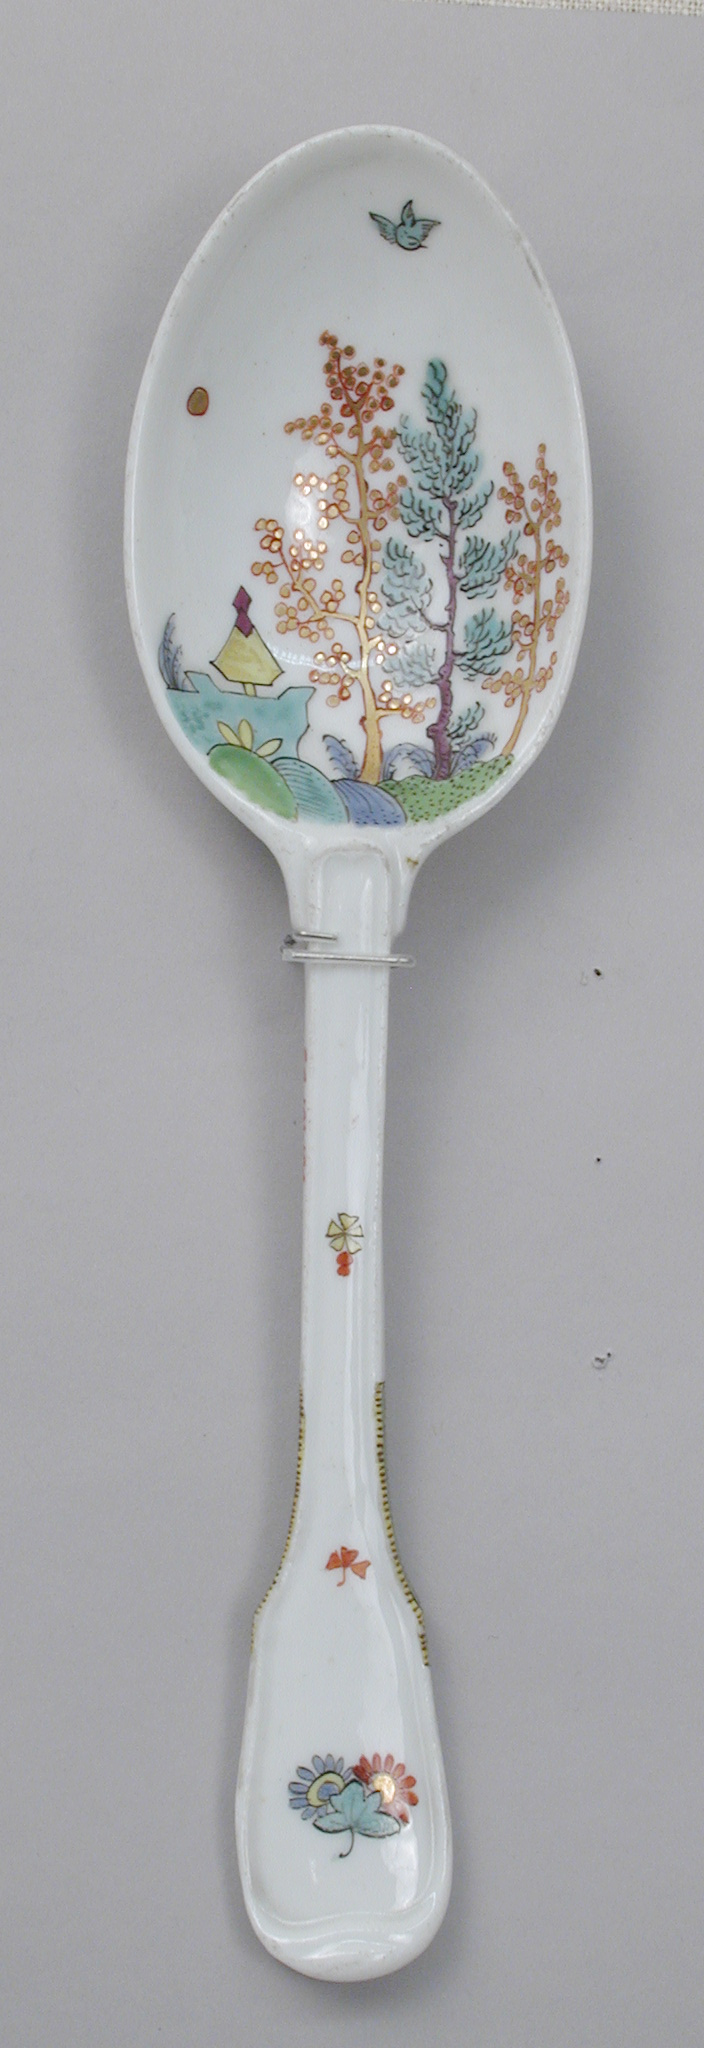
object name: spoon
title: Spoon with the arms of Johann Christian, Graf von Hennicke (1692–1752)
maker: meissen manufactory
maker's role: manufactory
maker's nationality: german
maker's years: 1710-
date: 1735-1740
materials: hard paste porcelain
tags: birds,flowers,trees,coat of arms